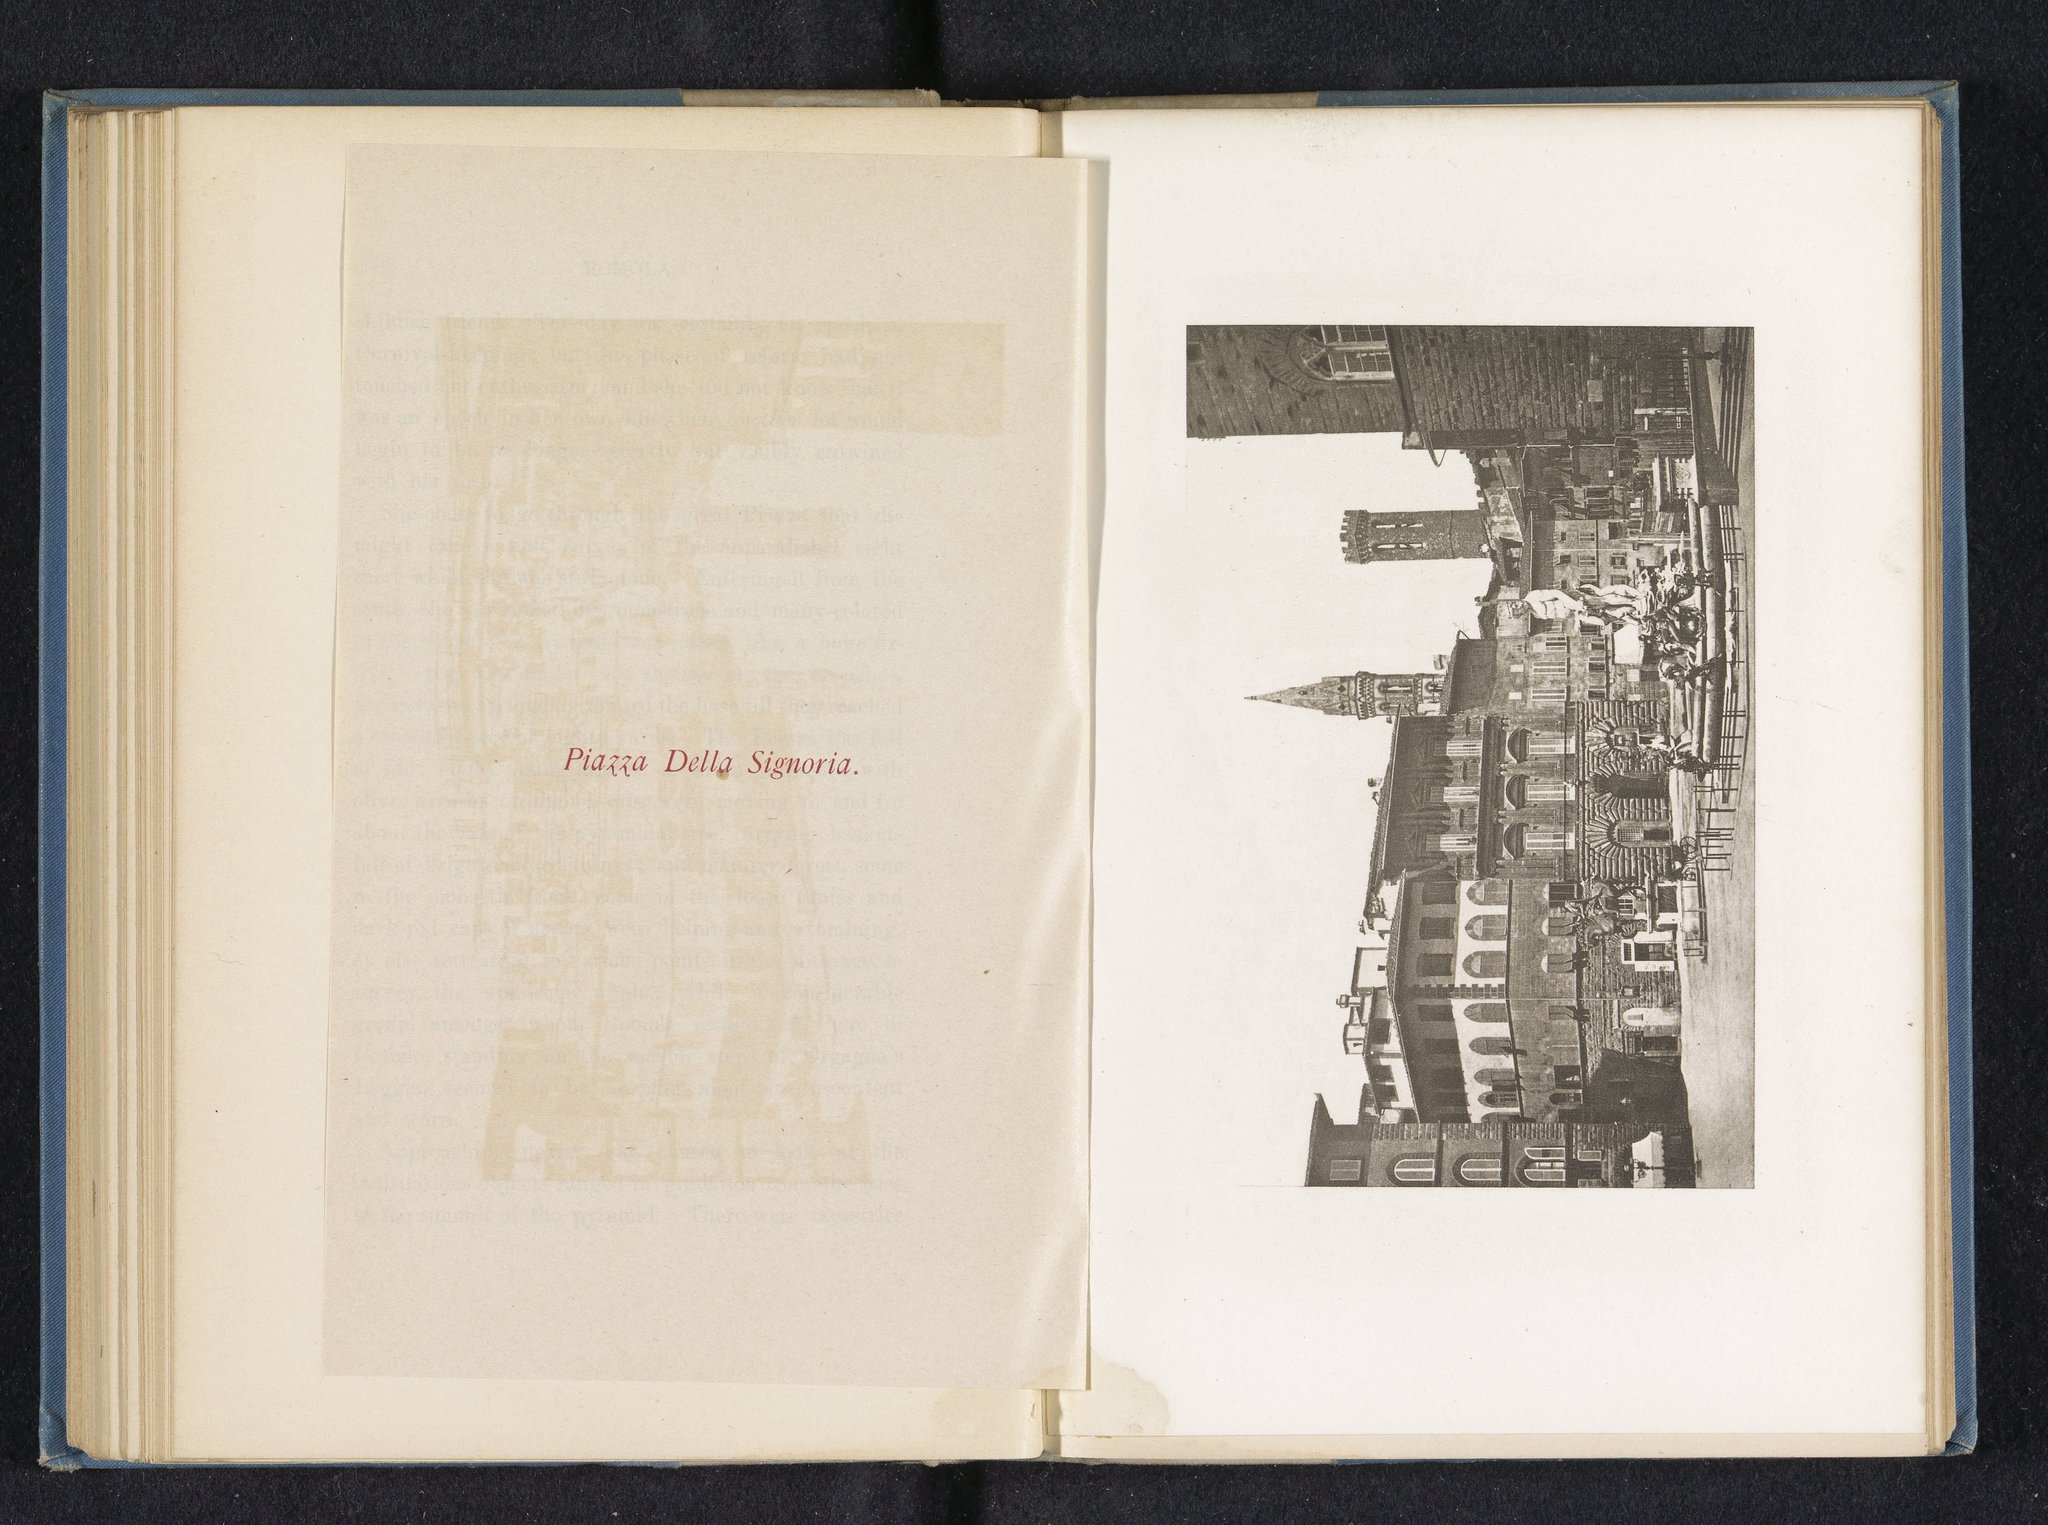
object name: photomechanical print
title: Gezicht op het Piazza della Signoria te Florence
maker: Anonymous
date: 1880-1890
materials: paper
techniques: photoaquatint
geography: piazza della signoria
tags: square, place, circus, etc., façade (of house or building)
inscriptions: title: ‘Piazza della Signoria.’